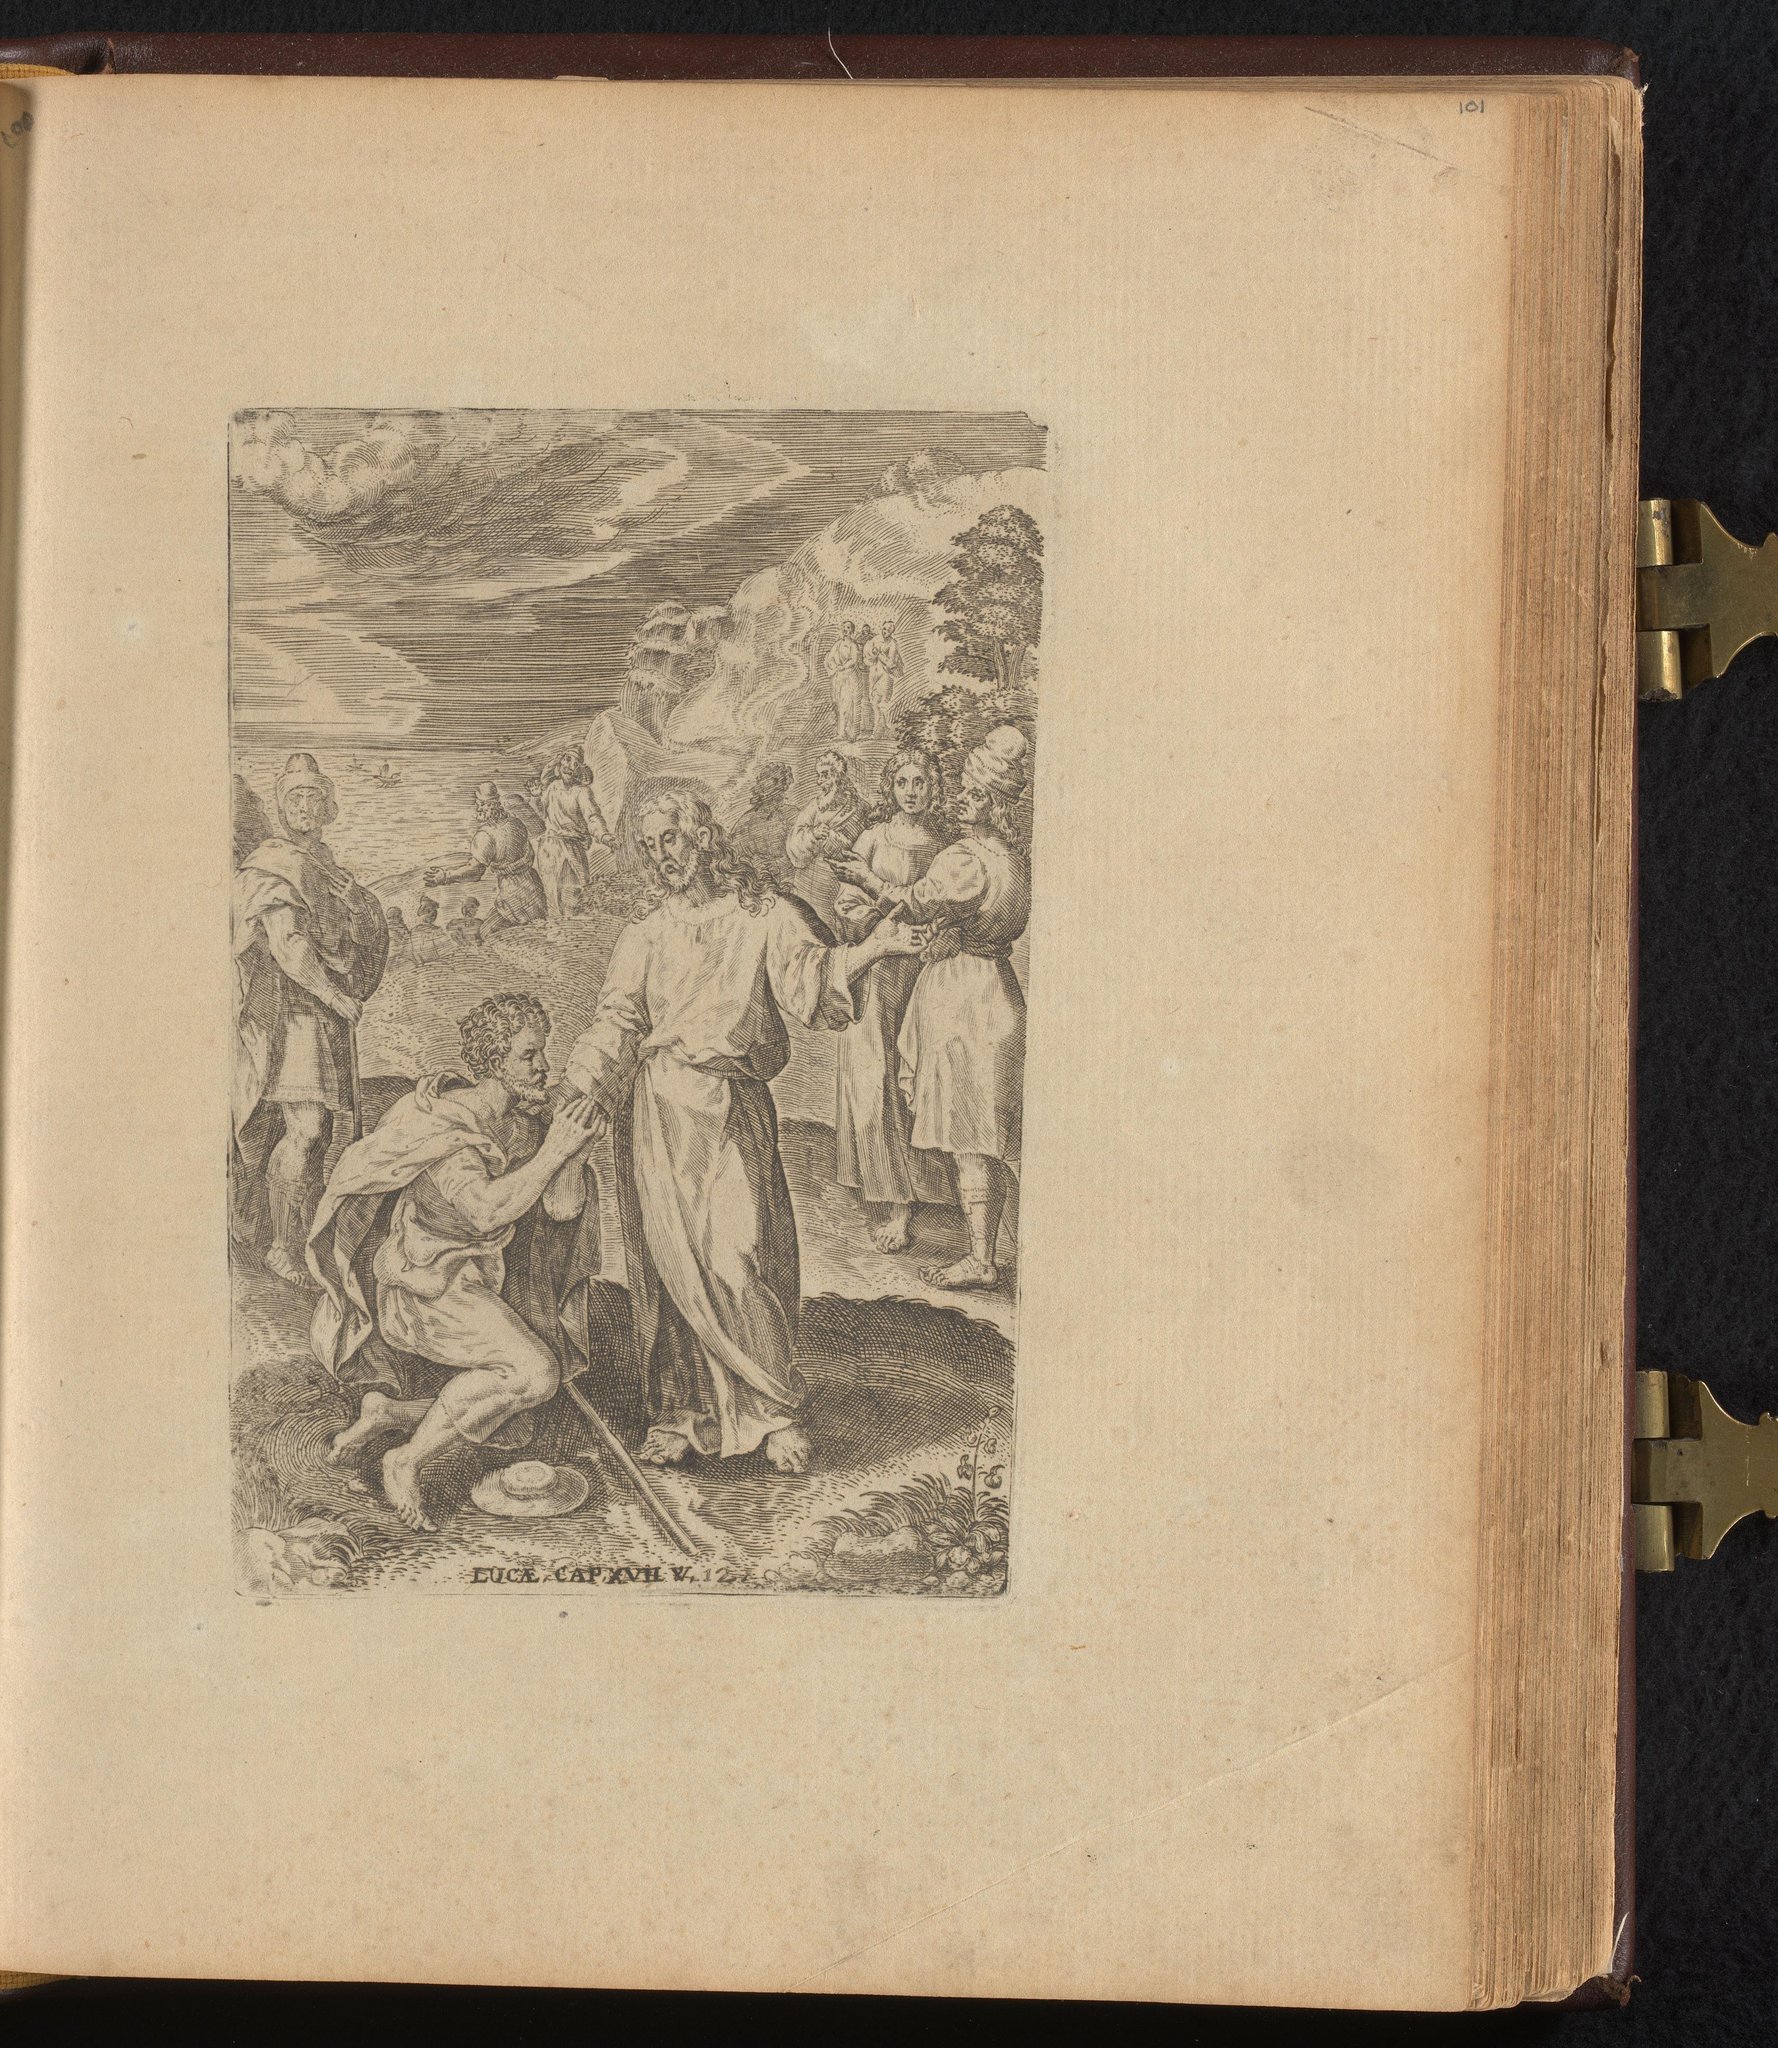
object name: album leaf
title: Christus geneest tien melaatsen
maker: Anonymous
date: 1583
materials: paper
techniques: engraving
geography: southern netherlands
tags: one leper, a samaritan, sent to the priest by christ, returns and kneels before him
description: Eerdere staat van prent gebruikt als boekillustratie in: Biblia Sacra. Antwerpen: Christoffel Plantijn, 1583.